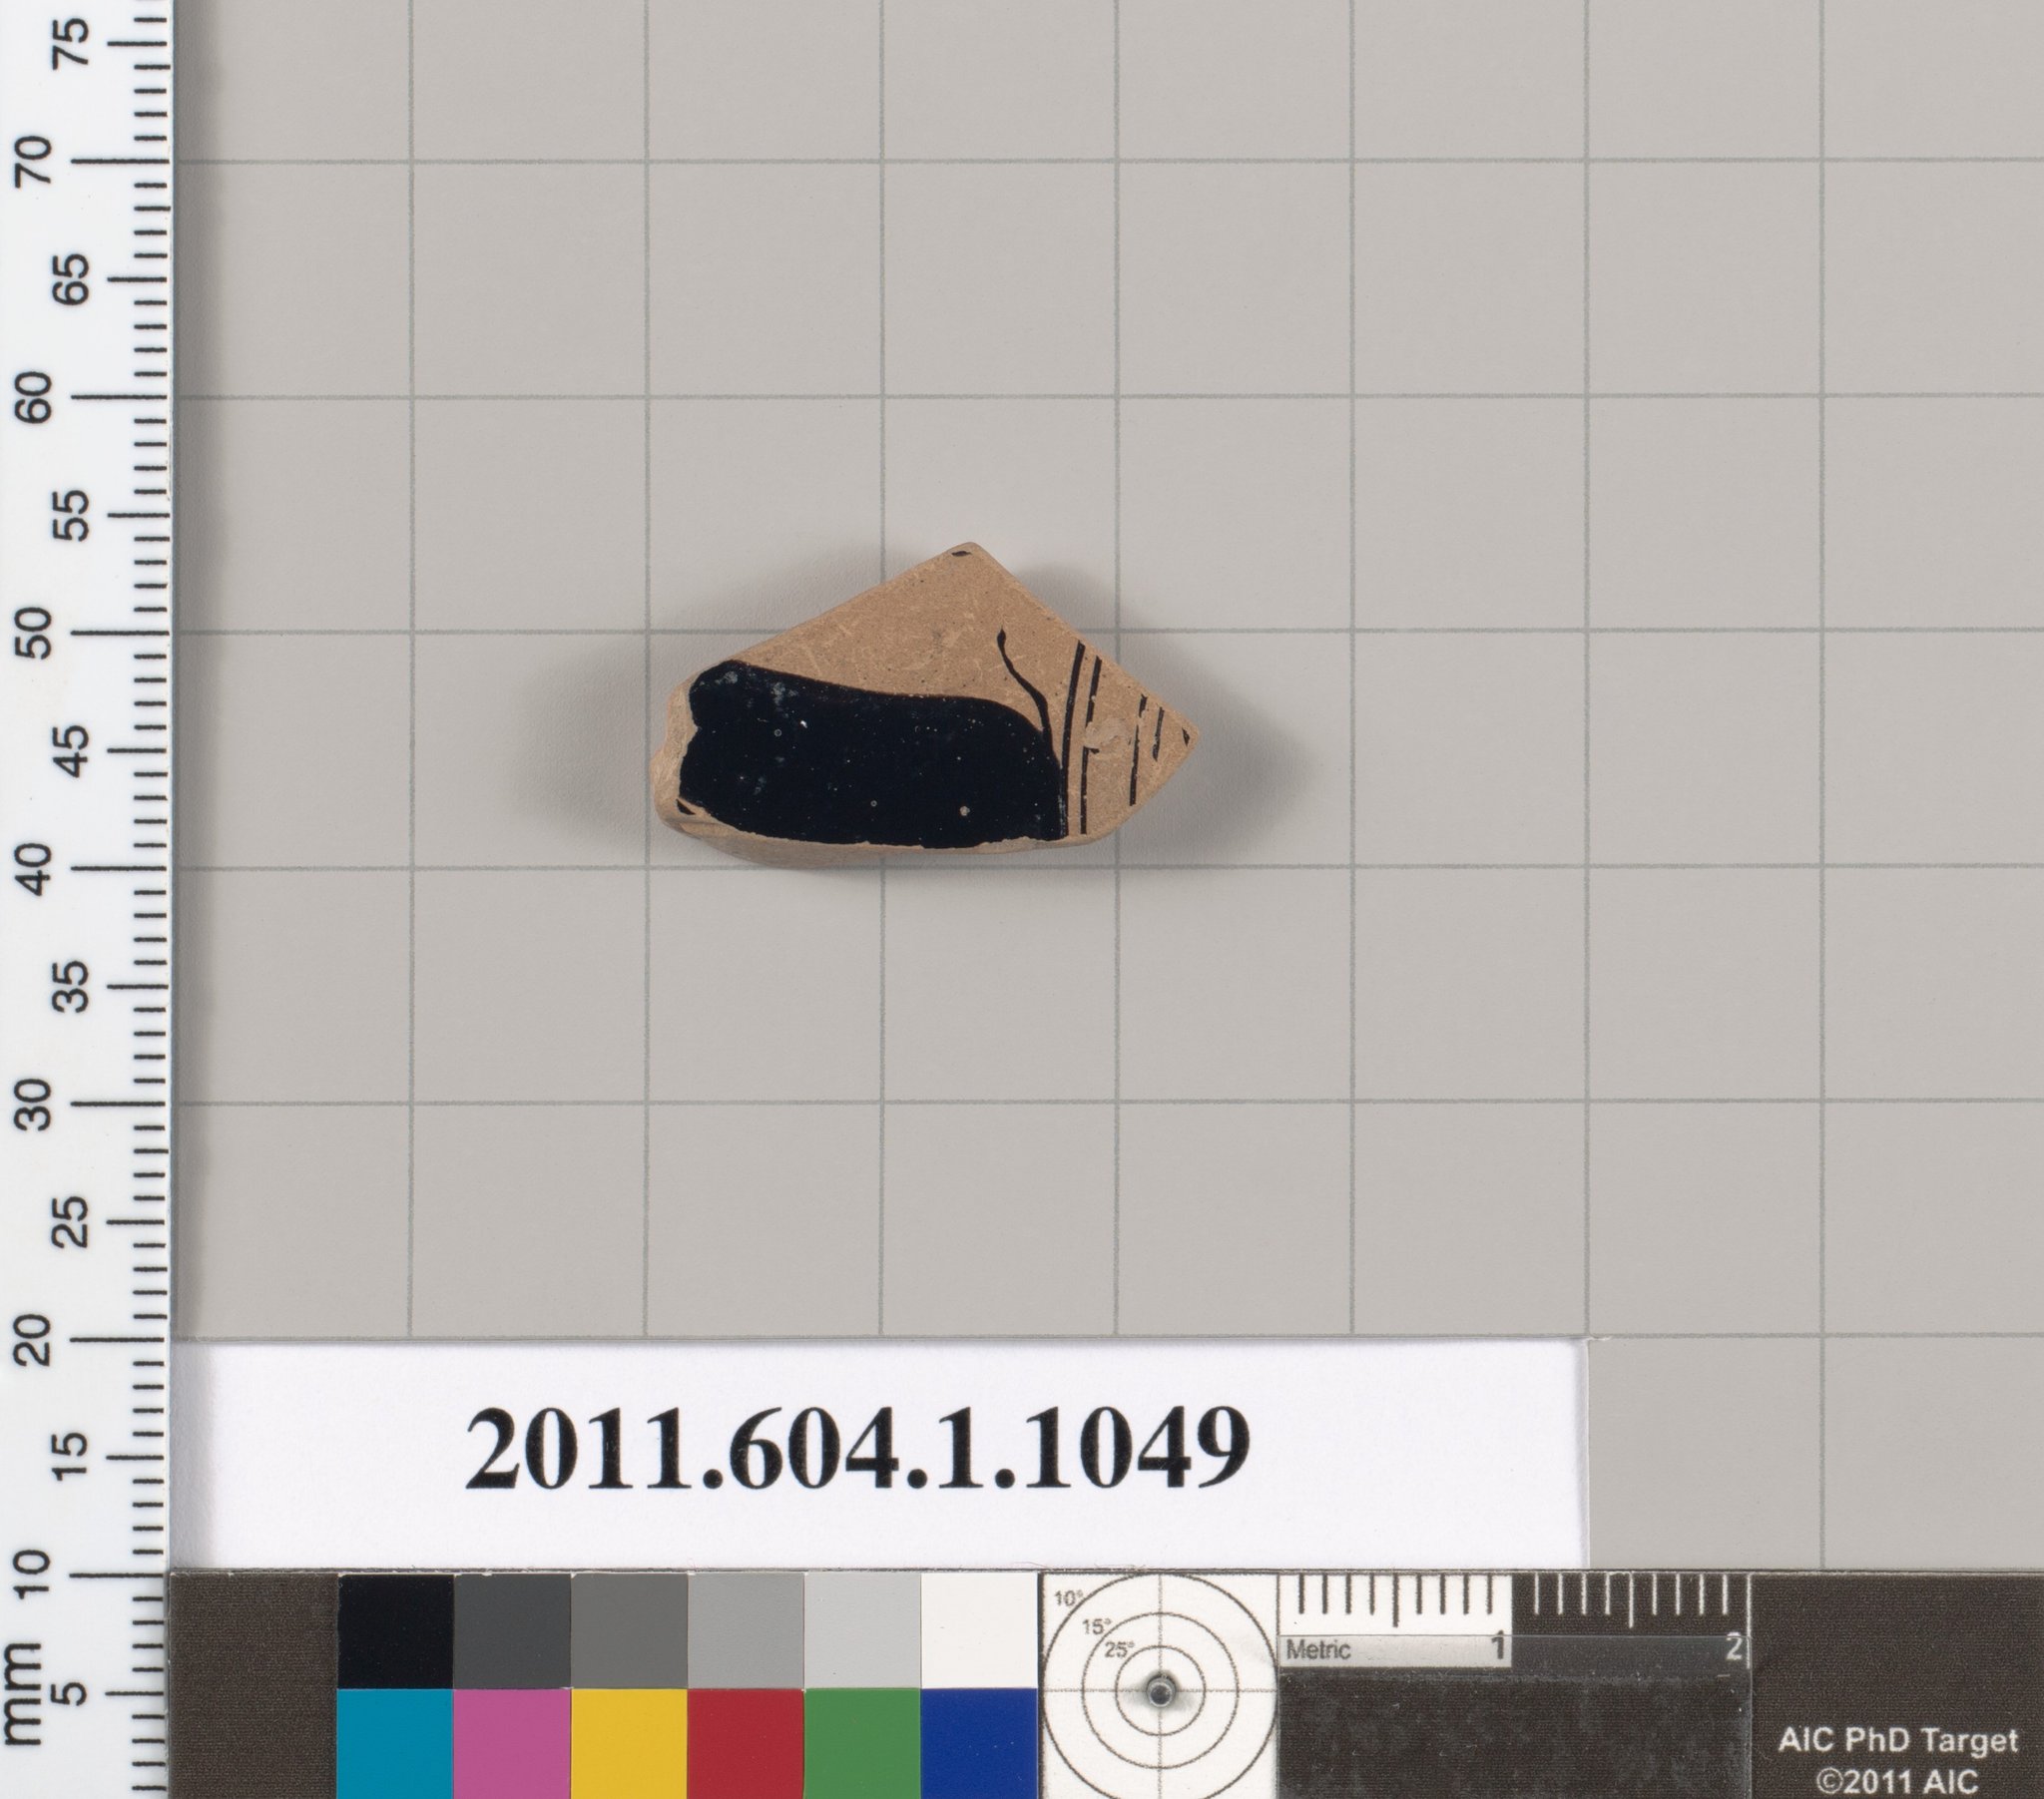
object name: kylix fragment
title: Terracotta fragment of a kylix (drinking cup)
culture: greek, attic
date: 475-451 BCE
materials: terracotta